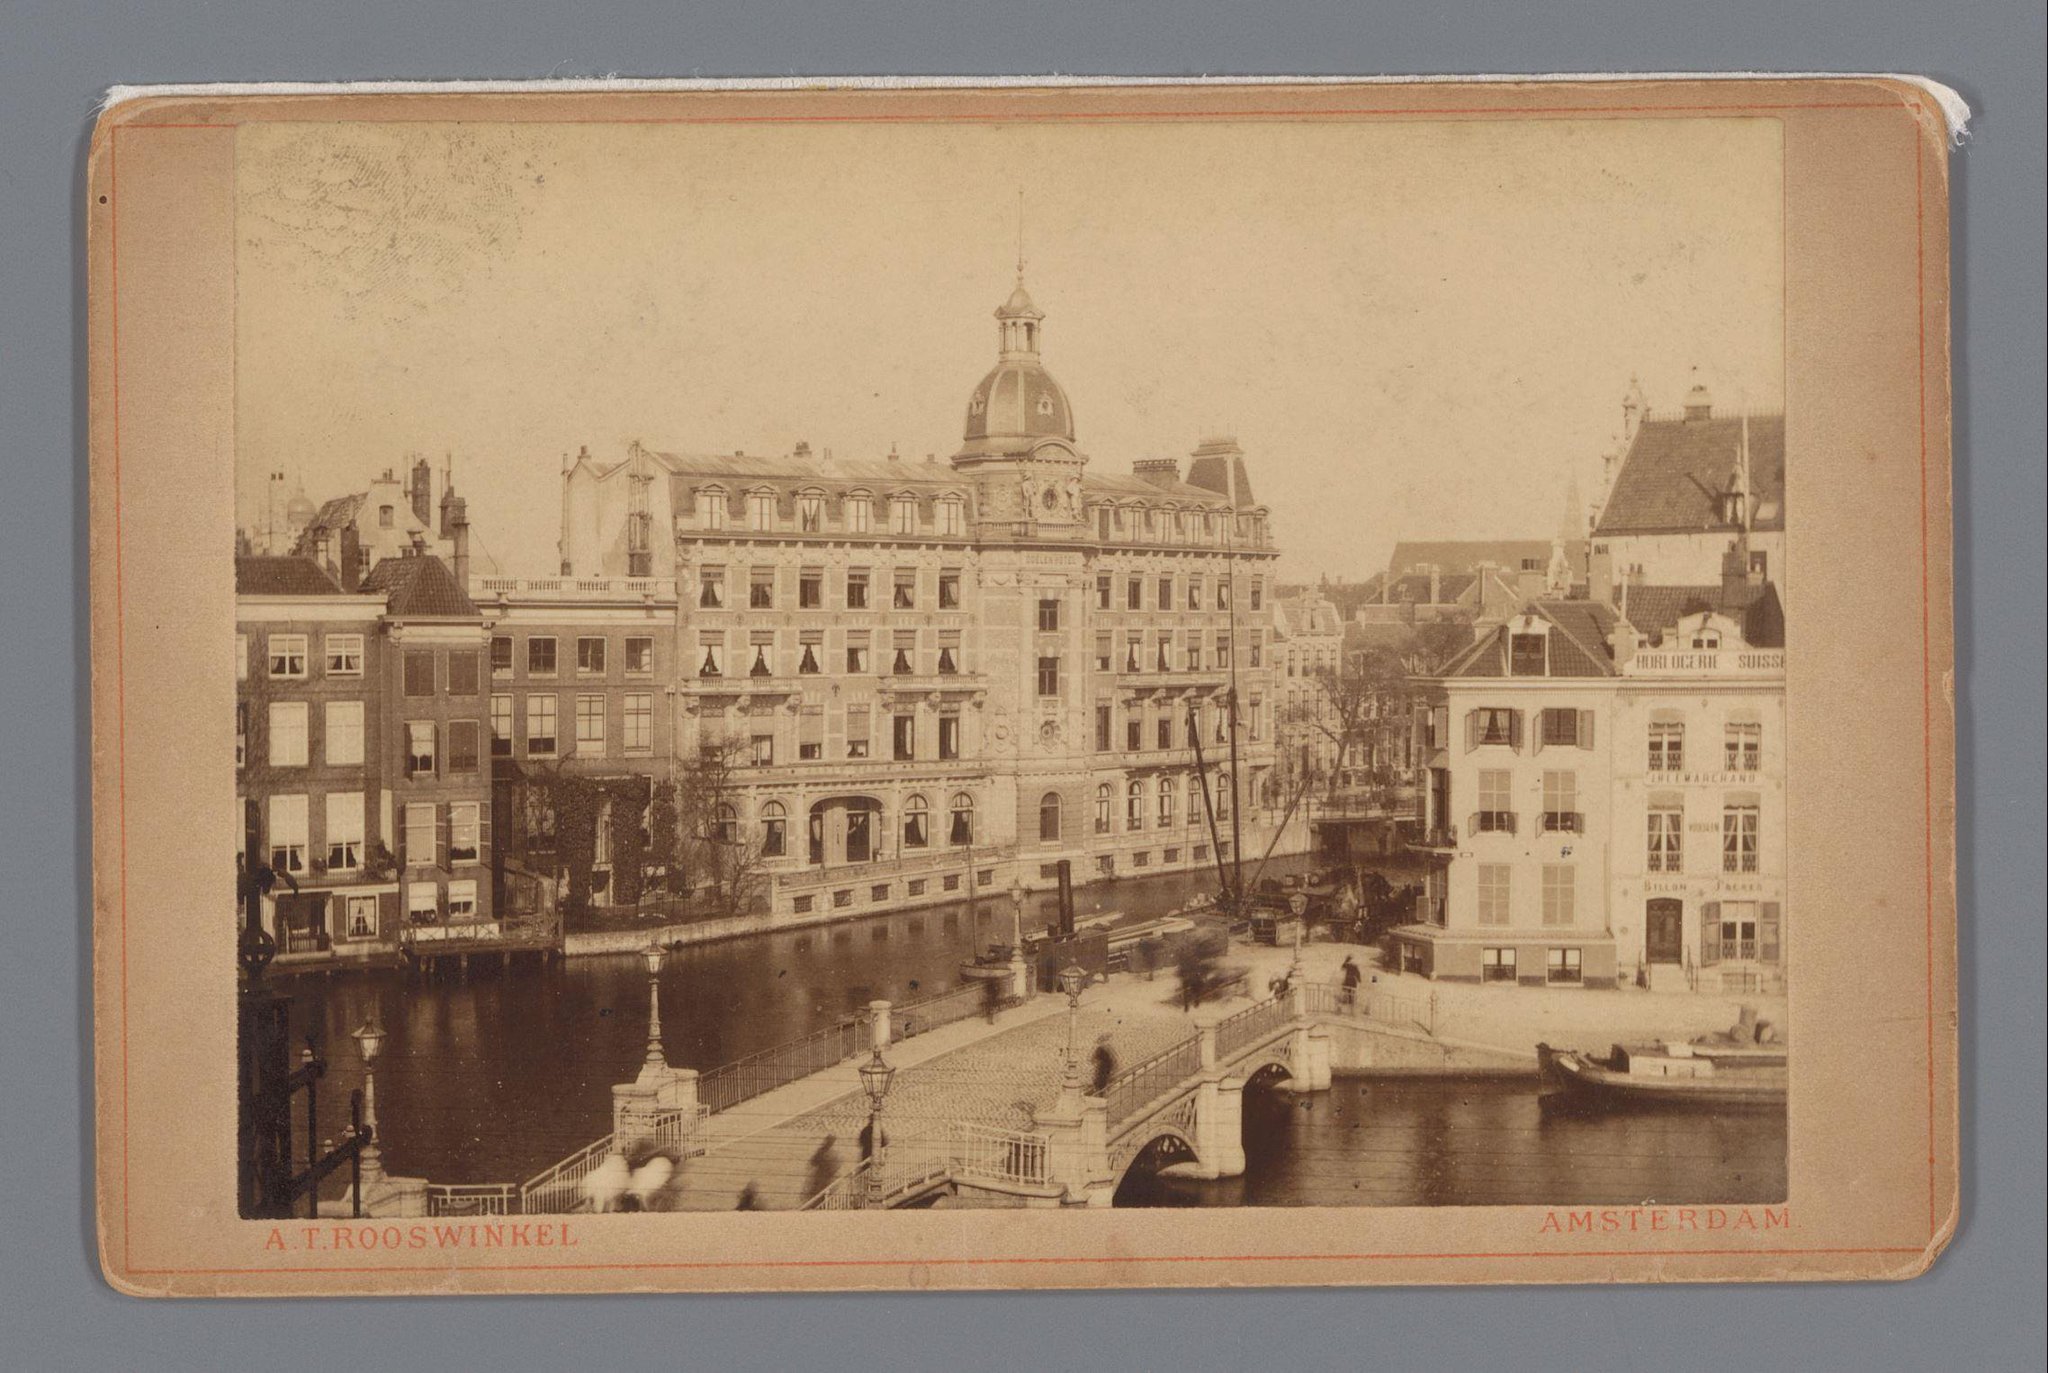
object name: photograph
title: Gezicht op het Doelenhotel met de Amstel te Amsterdam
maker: andreas theodorus rooswinkel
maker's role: fotograaf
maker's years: 1838-1909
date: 1883-1900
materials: cardboard, photographic support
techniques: albumen print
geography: amsterdam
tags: hotel, hostelry, inn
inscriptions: annotation: ‘Doelenhotel/ geschenk 1982’, retailer's mark: ‘Binnen-en Buitenlandsche Boekhandel/ Abrahamson & Co./ Oude Hoogstraat 20/ Amsterdam’, inscription: ‘A. Trooswinkel/ Amsterdam’